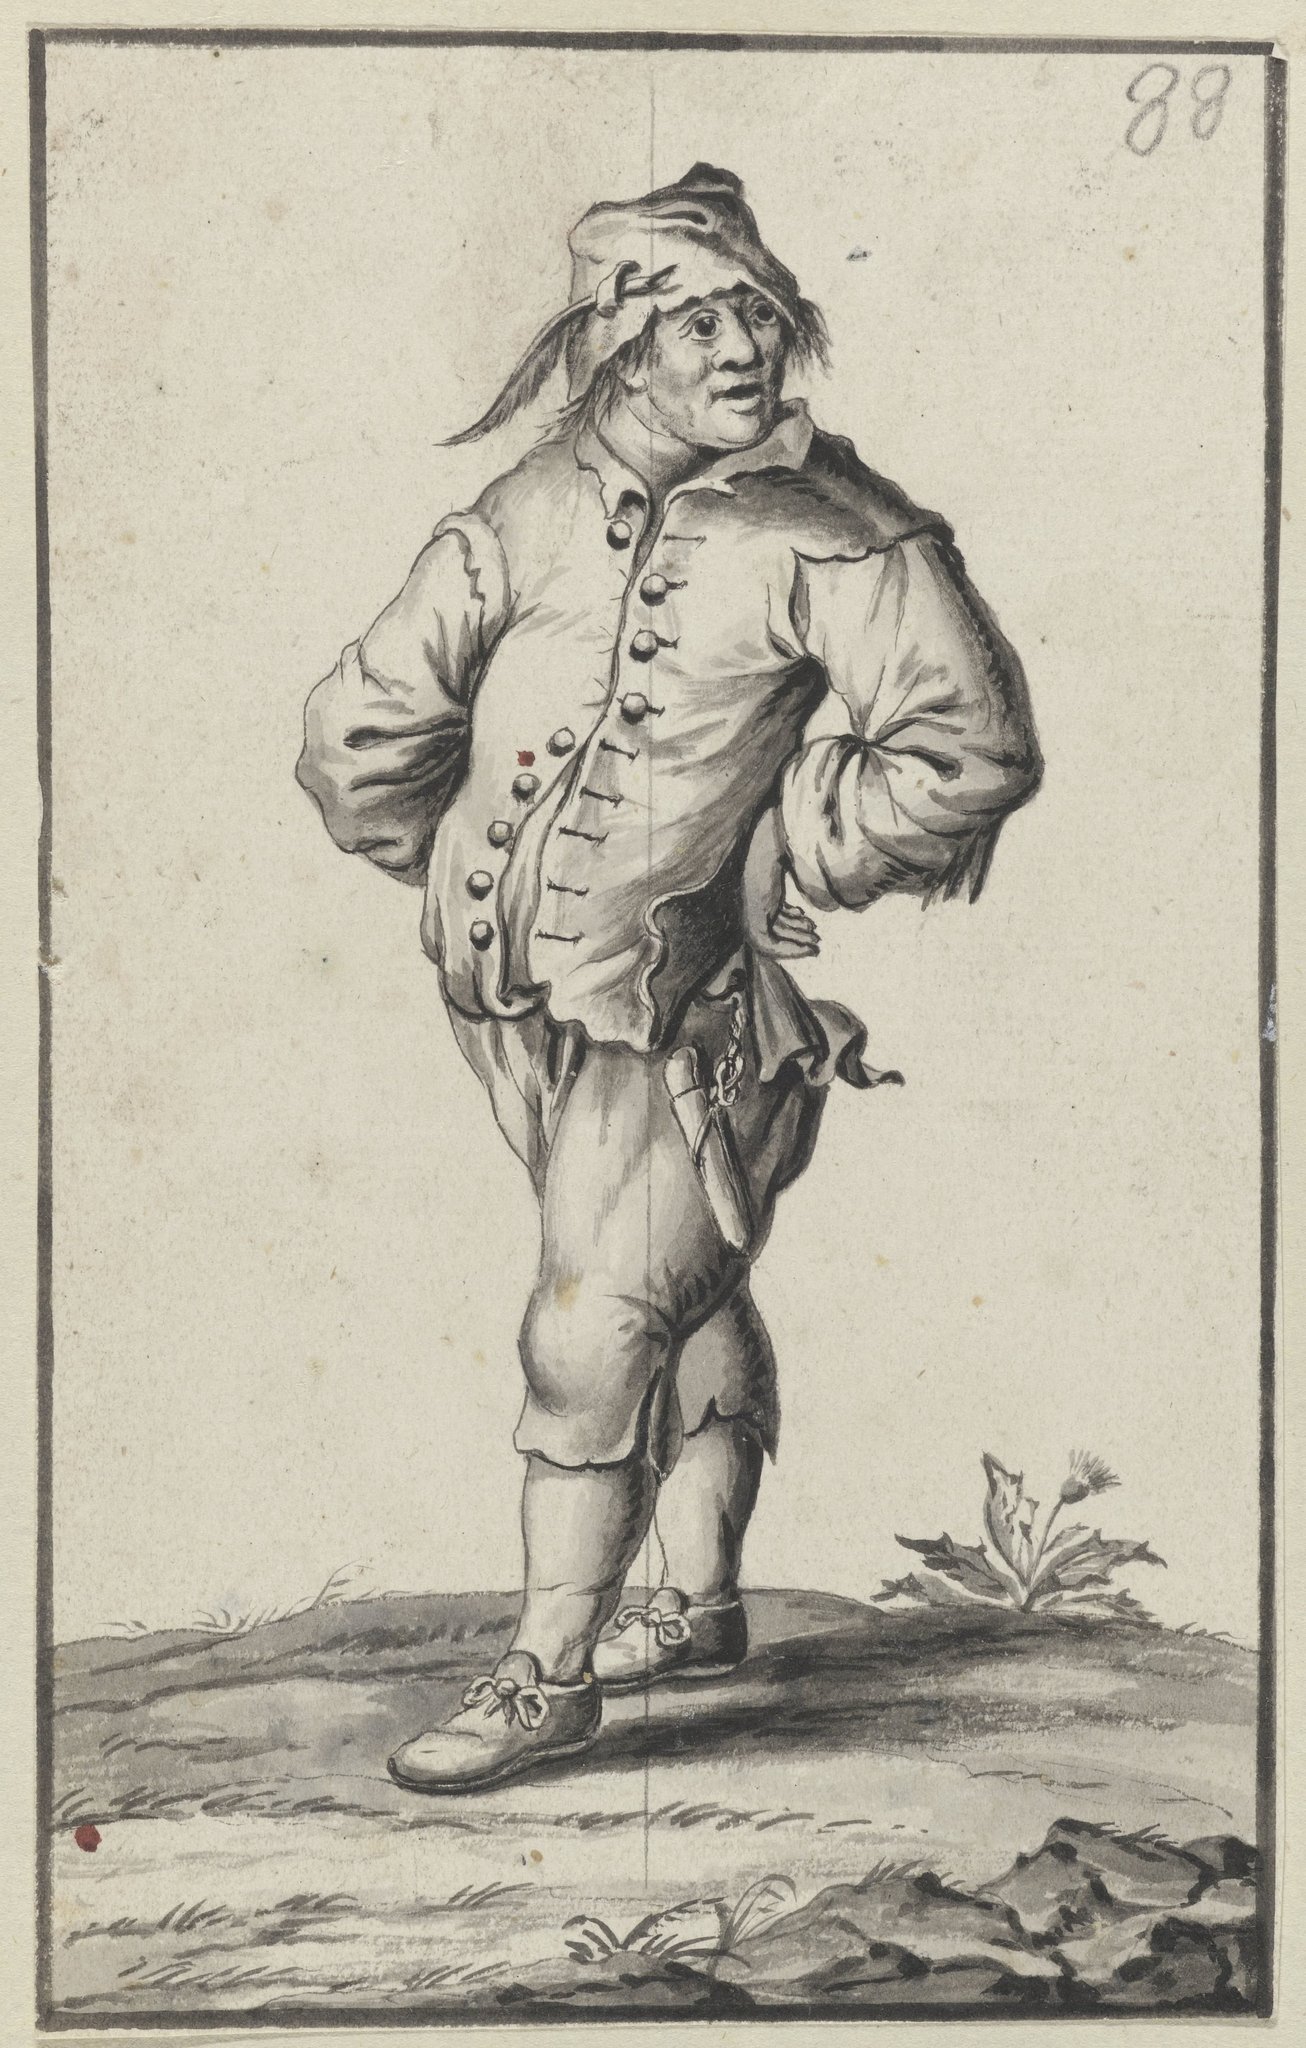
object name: drawing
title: Staande man met de handen in de zij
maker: Anonymous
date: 1700-1799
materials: ink, paper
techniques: brush, pen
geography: netherlands